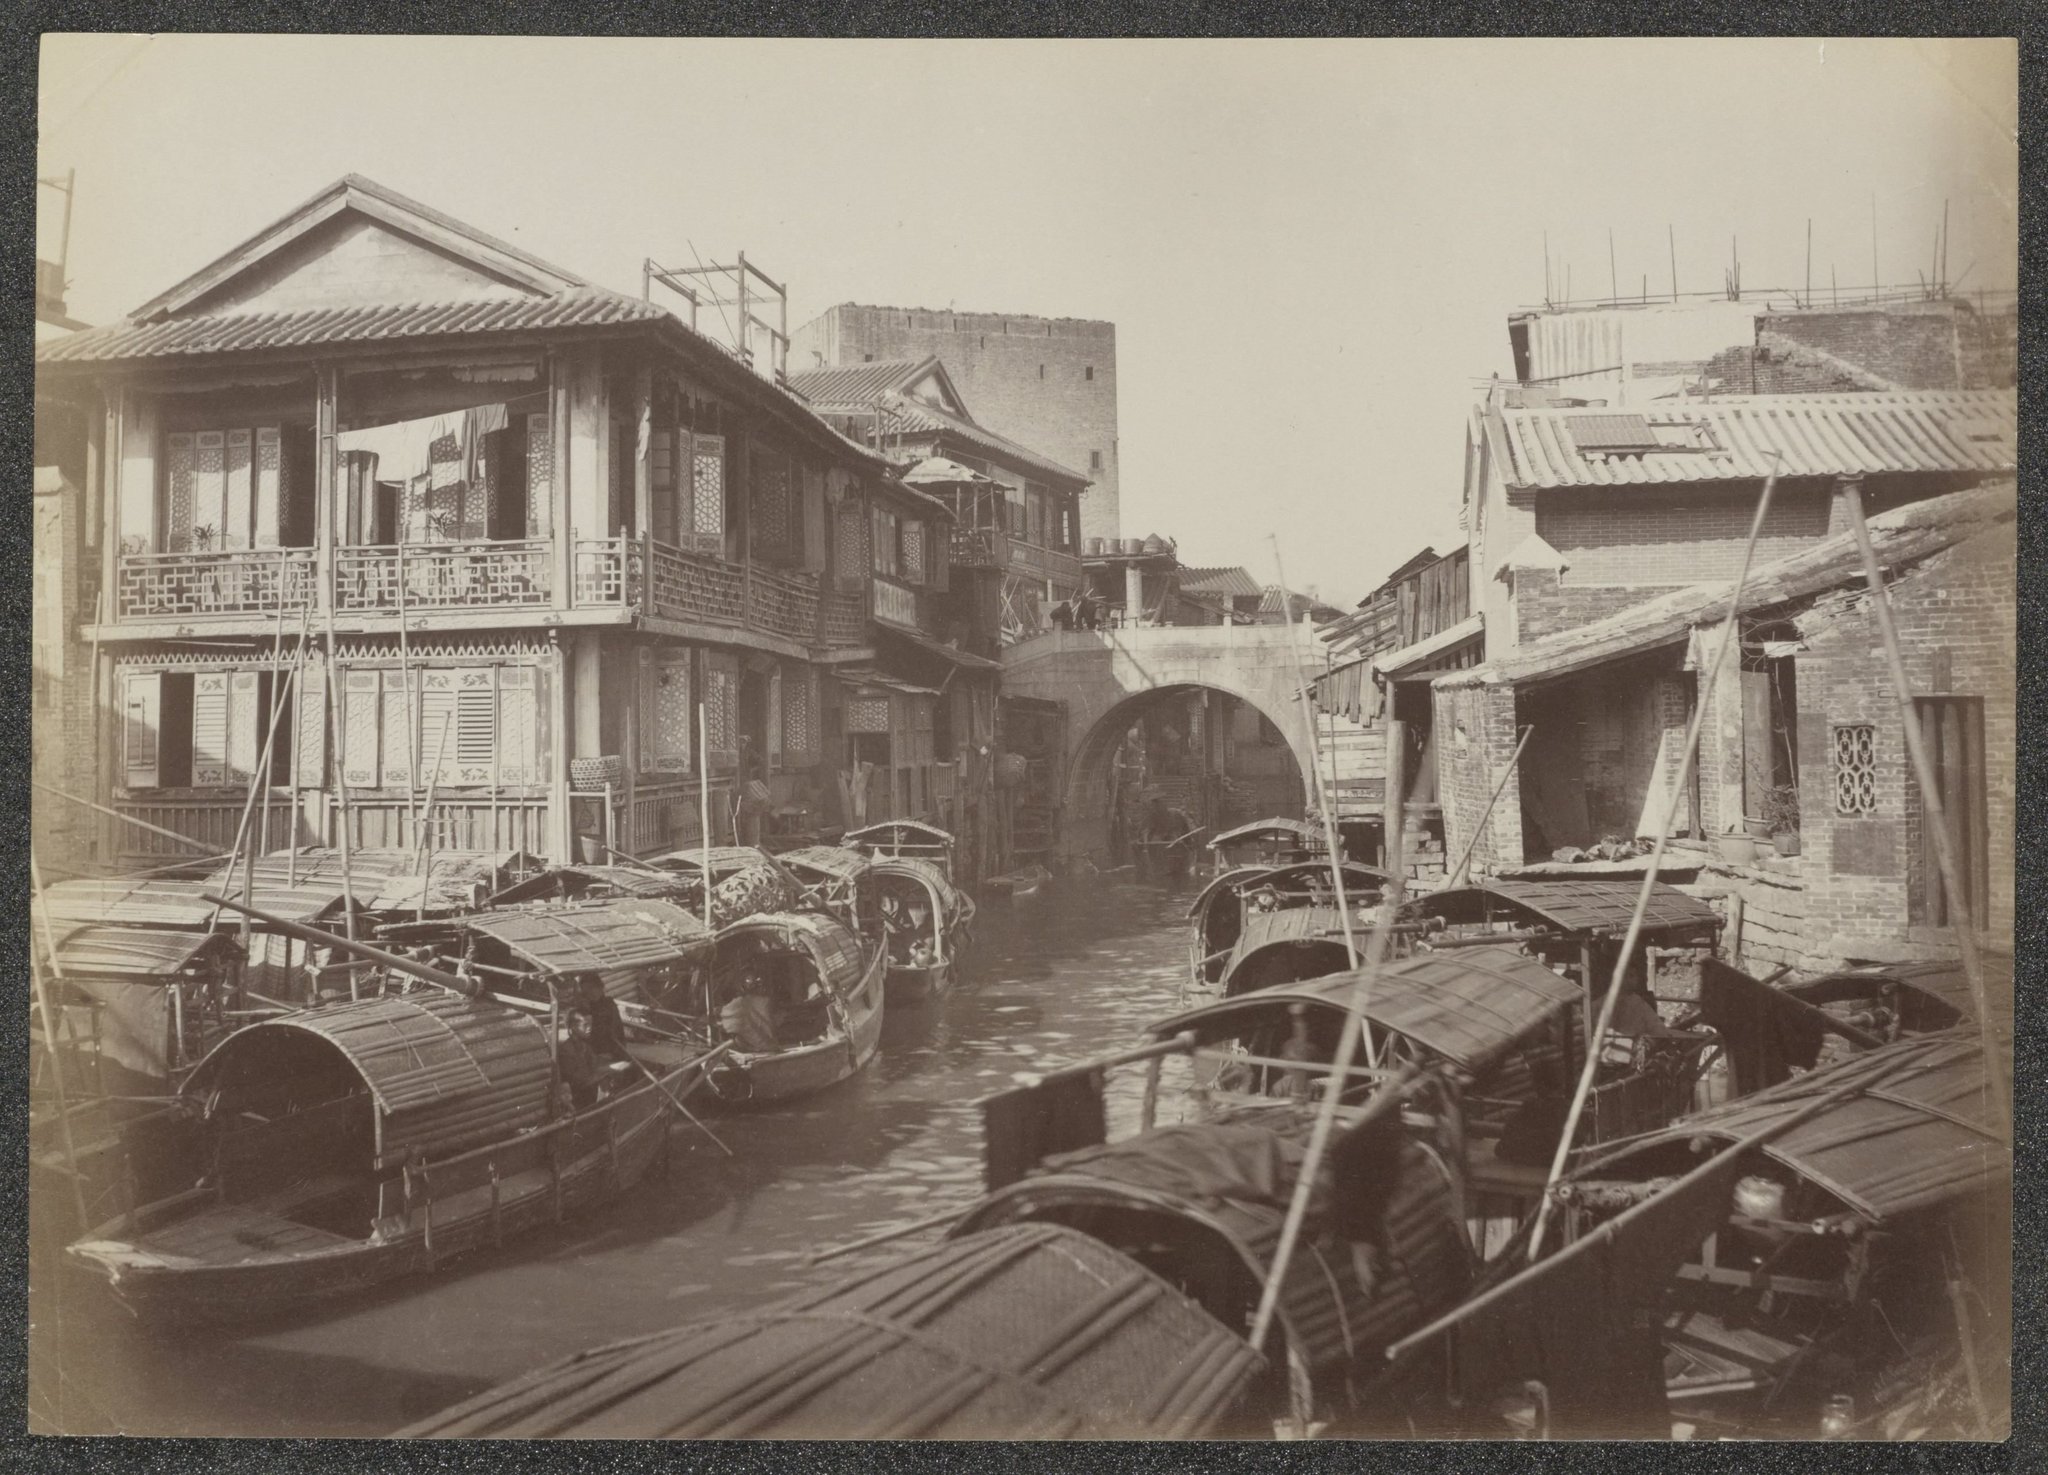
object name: album leaf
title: Boten en huizen in Kanton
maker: Anonymous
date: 1860-1900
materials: paper, photographic support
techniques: albumen print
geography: guangdong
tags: harbour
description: Onderdeel van Album met 50 foto's van een reis door Zuidoost-Azië.